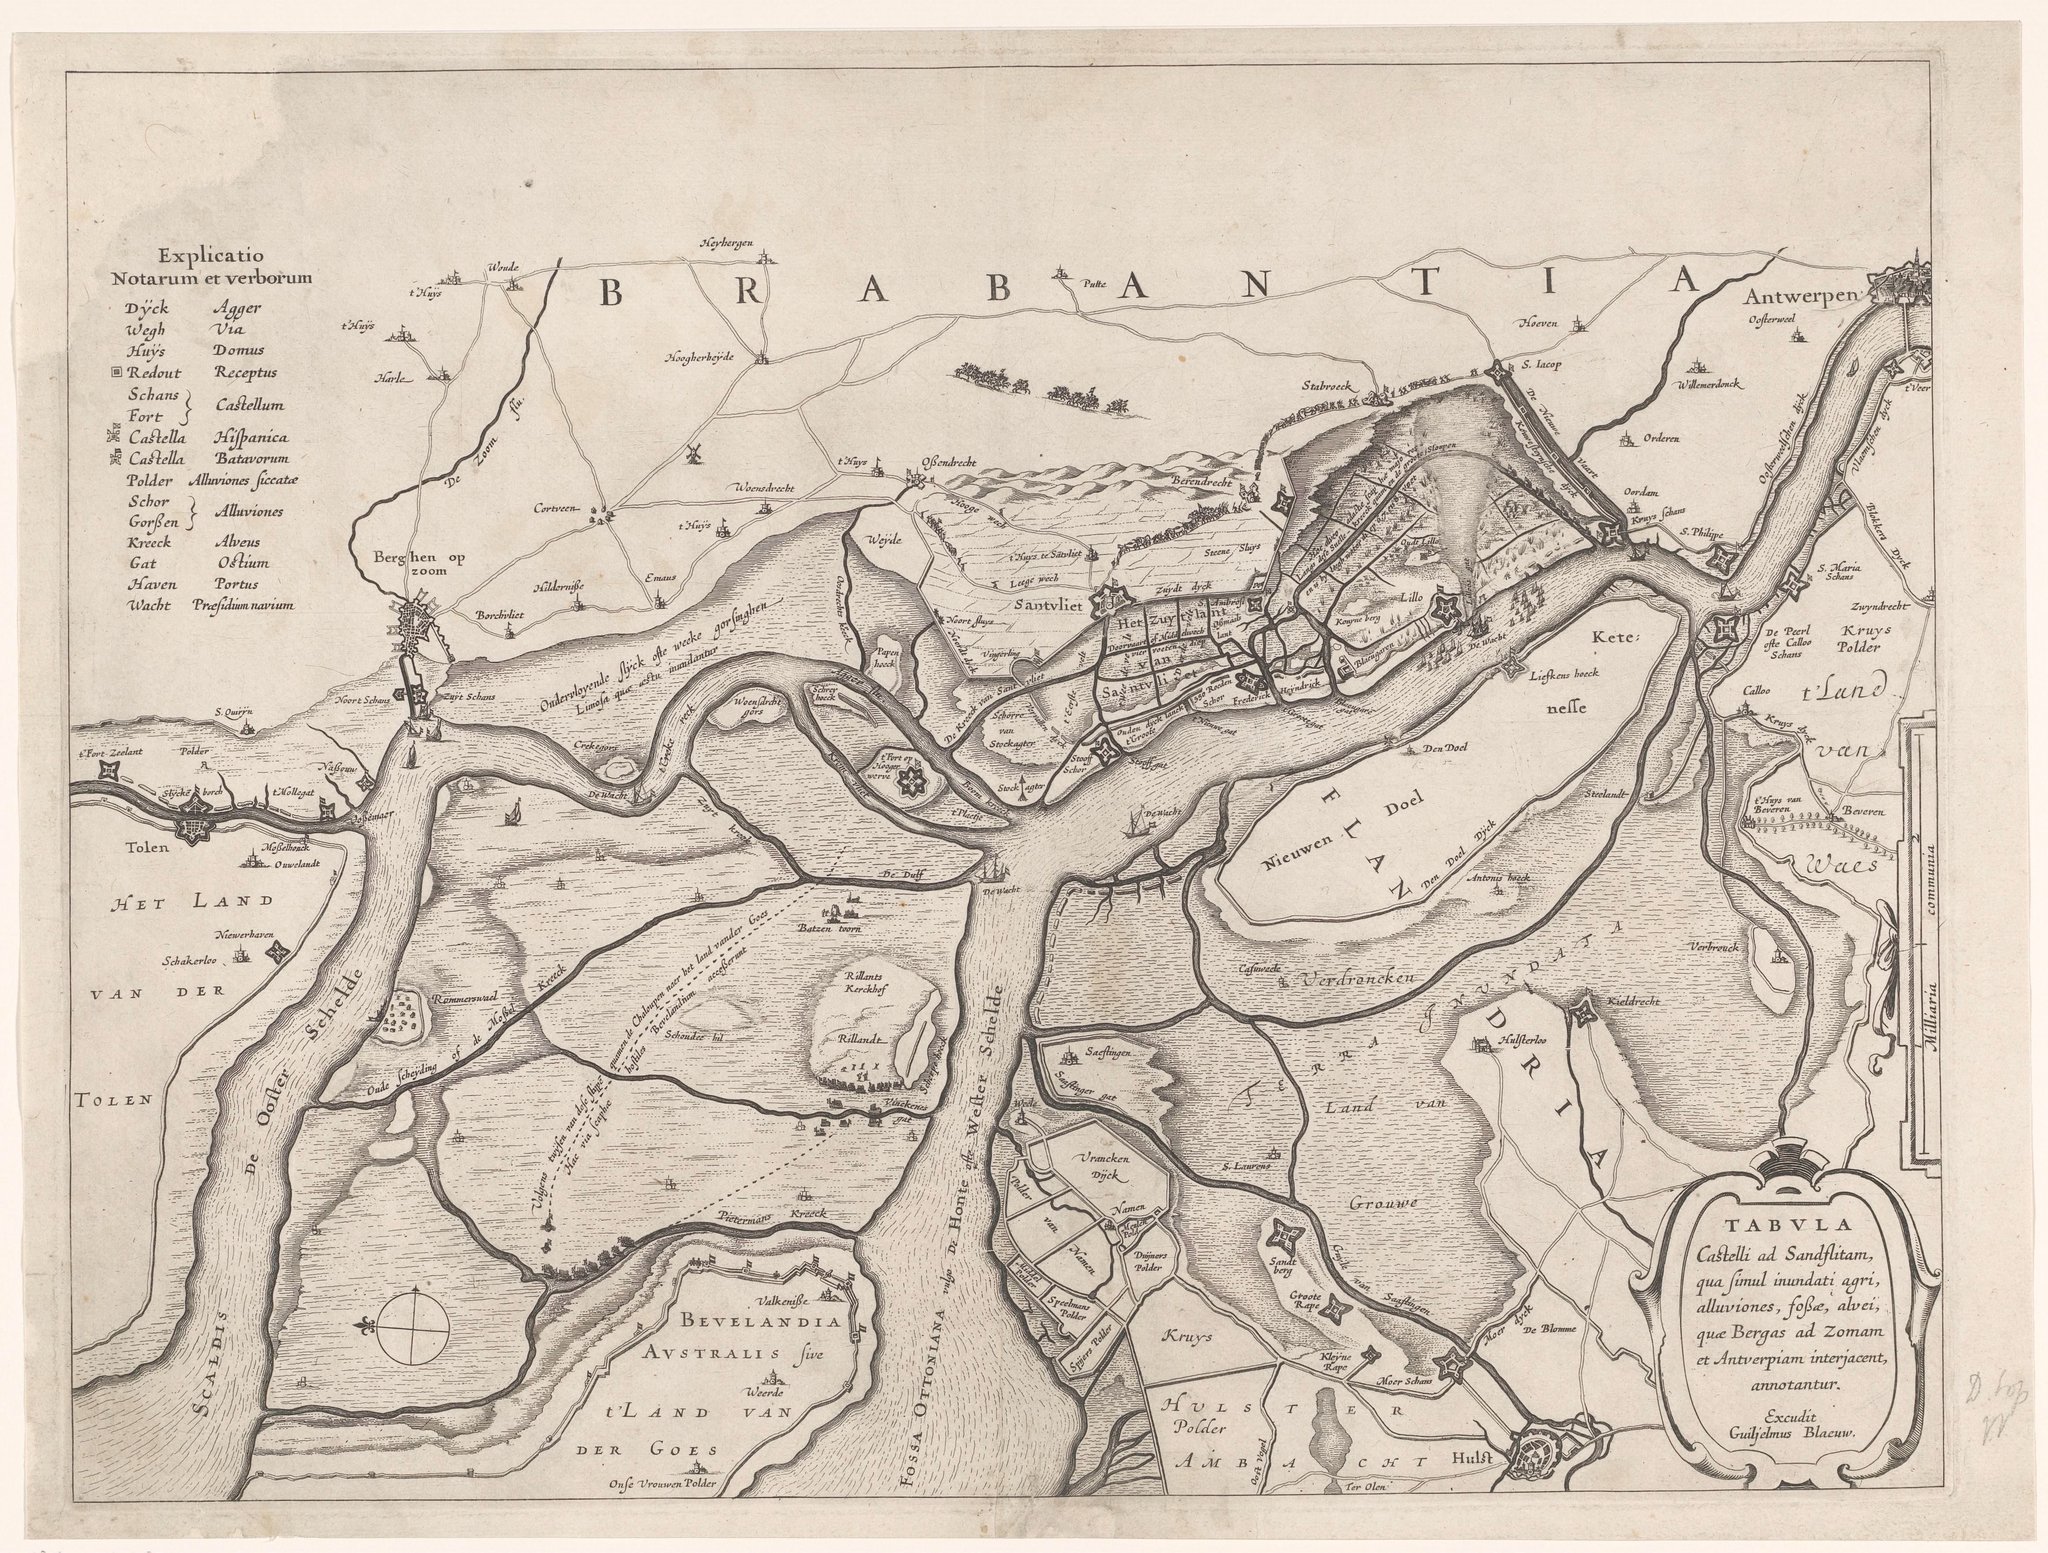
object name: print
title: Forten aan de Ooster- en Westerschelde, 1627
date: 1629-1672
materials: paper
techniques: engraving, etching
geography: amsterdam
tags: delft, the hague, frederick henry (prince of orange), maps of separate countries or regions, antwerp, bergen op zoom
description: Kaart van forten aan de Ooster- en Westerschelde en rond Zandvliet, 1627. Wellicht in relatie met de aanslag door Spinola op Zuid-Beveland, september 1627. Linksboven de vertaling van termen Nederlands - Latijn. Rechtsonder een cartouche met de titel. Rechts, in het midden, een schaalstok: 2 Milliaria communia.